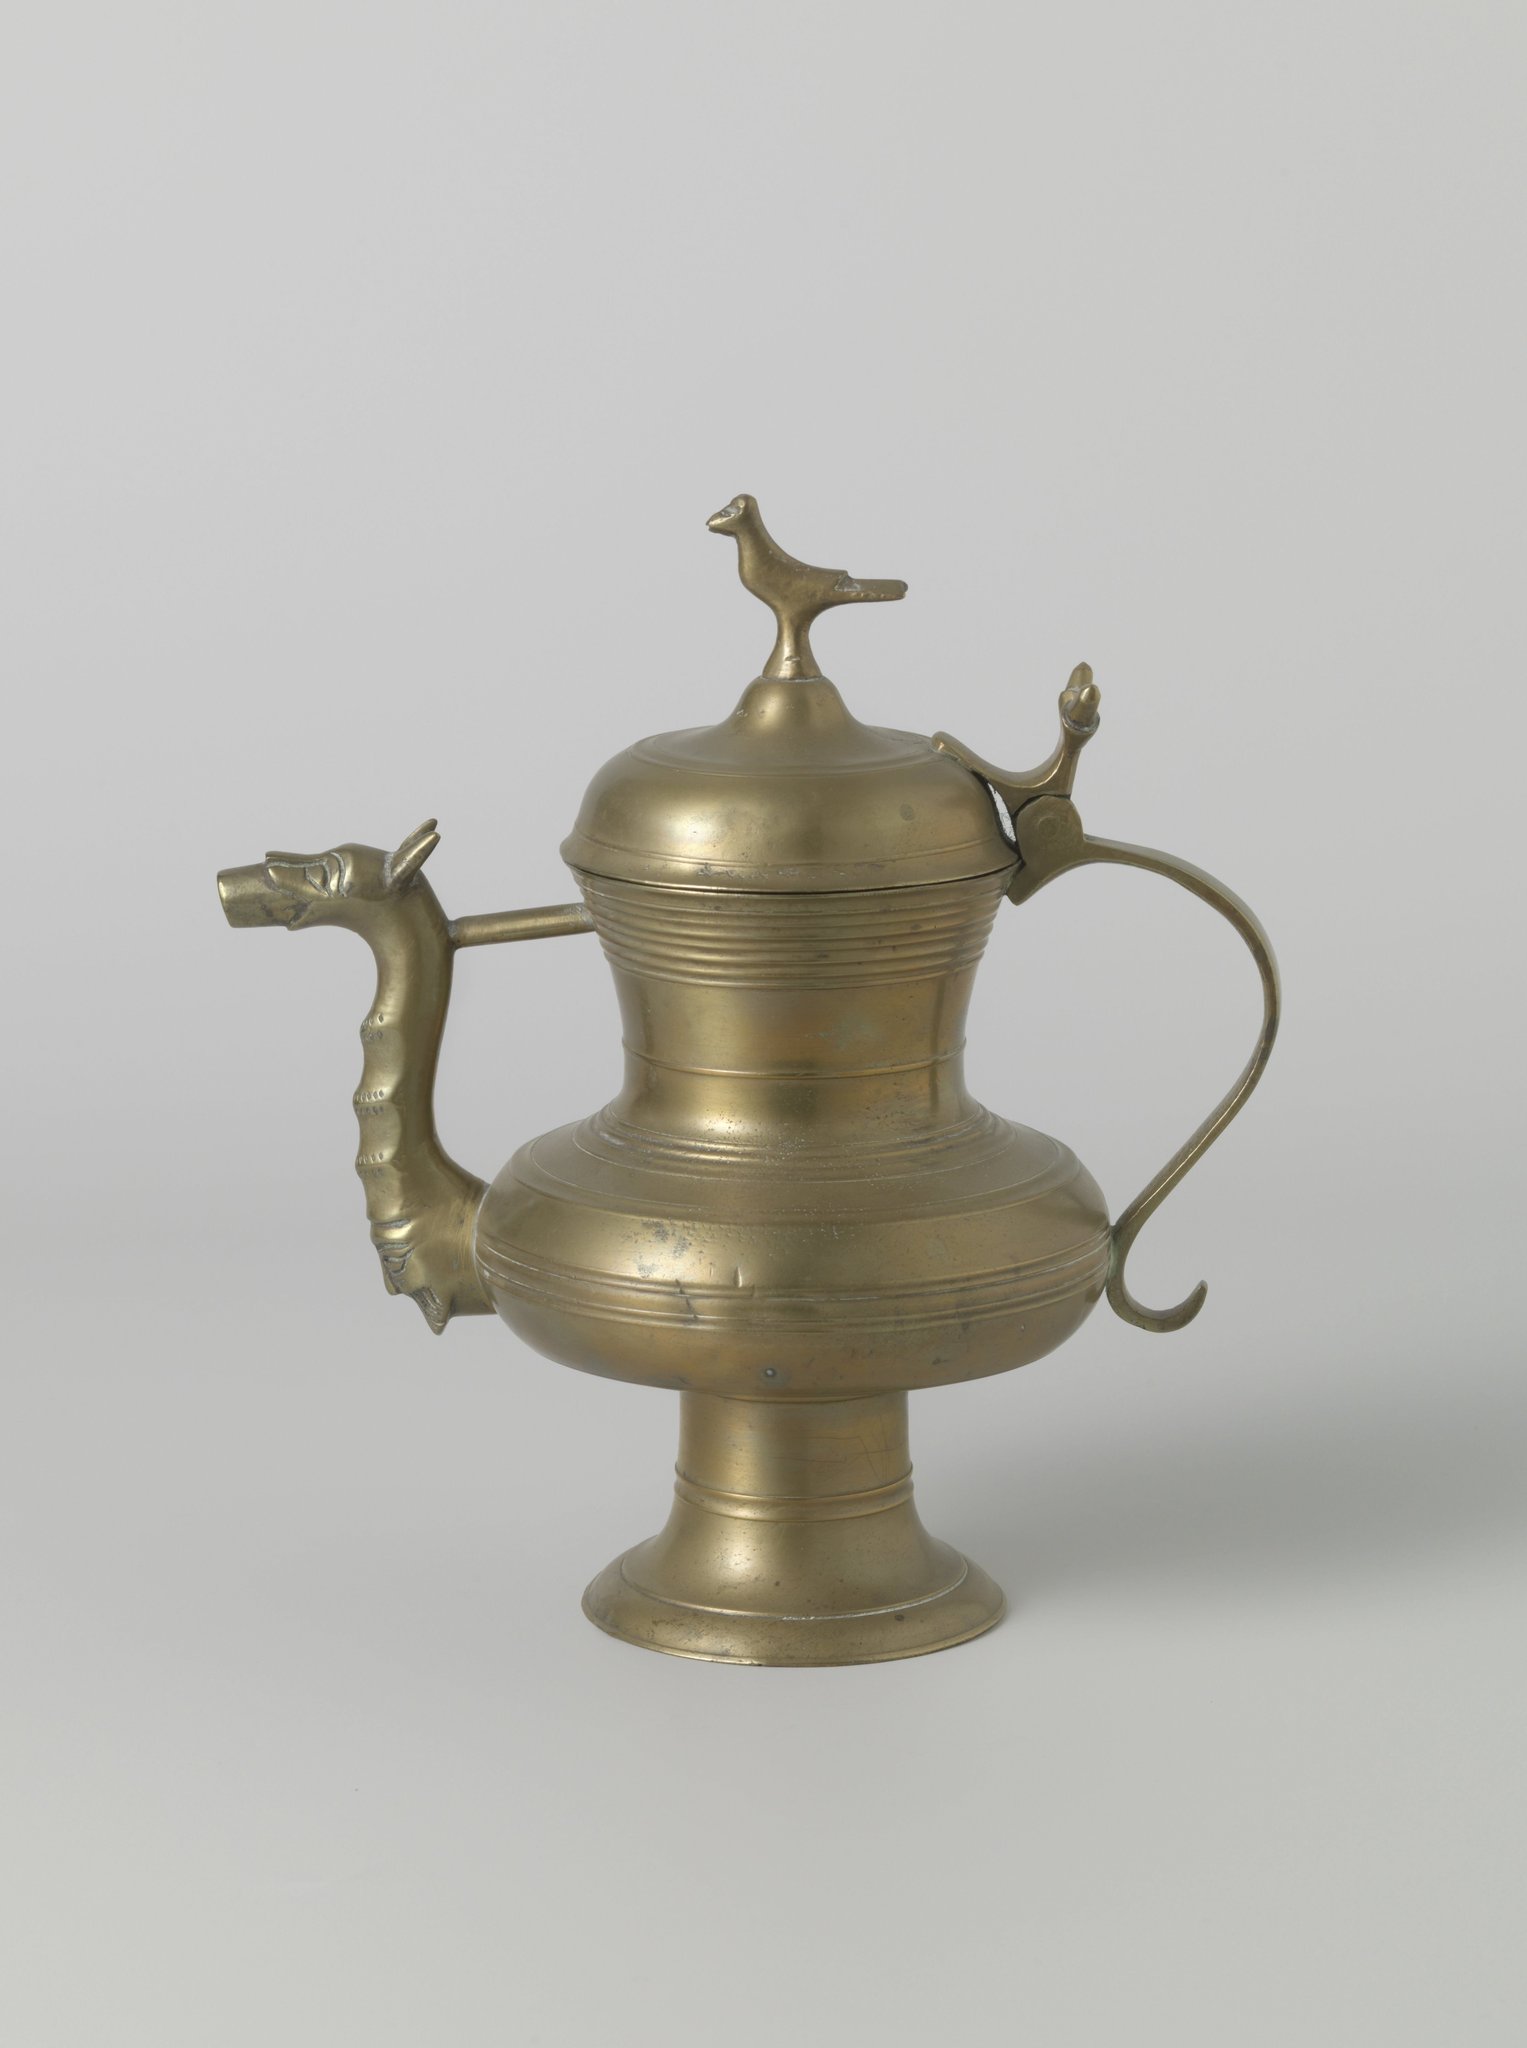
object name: ewer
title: Kan met tuit in de vorm van een drakenkop met hals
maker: Anonymous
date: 1475-1525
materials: brass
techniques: brazing, casting, metalworking, turning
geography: nuremberg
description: Jug. Brass. Nüremberg (?), c. 1475 - 1525.